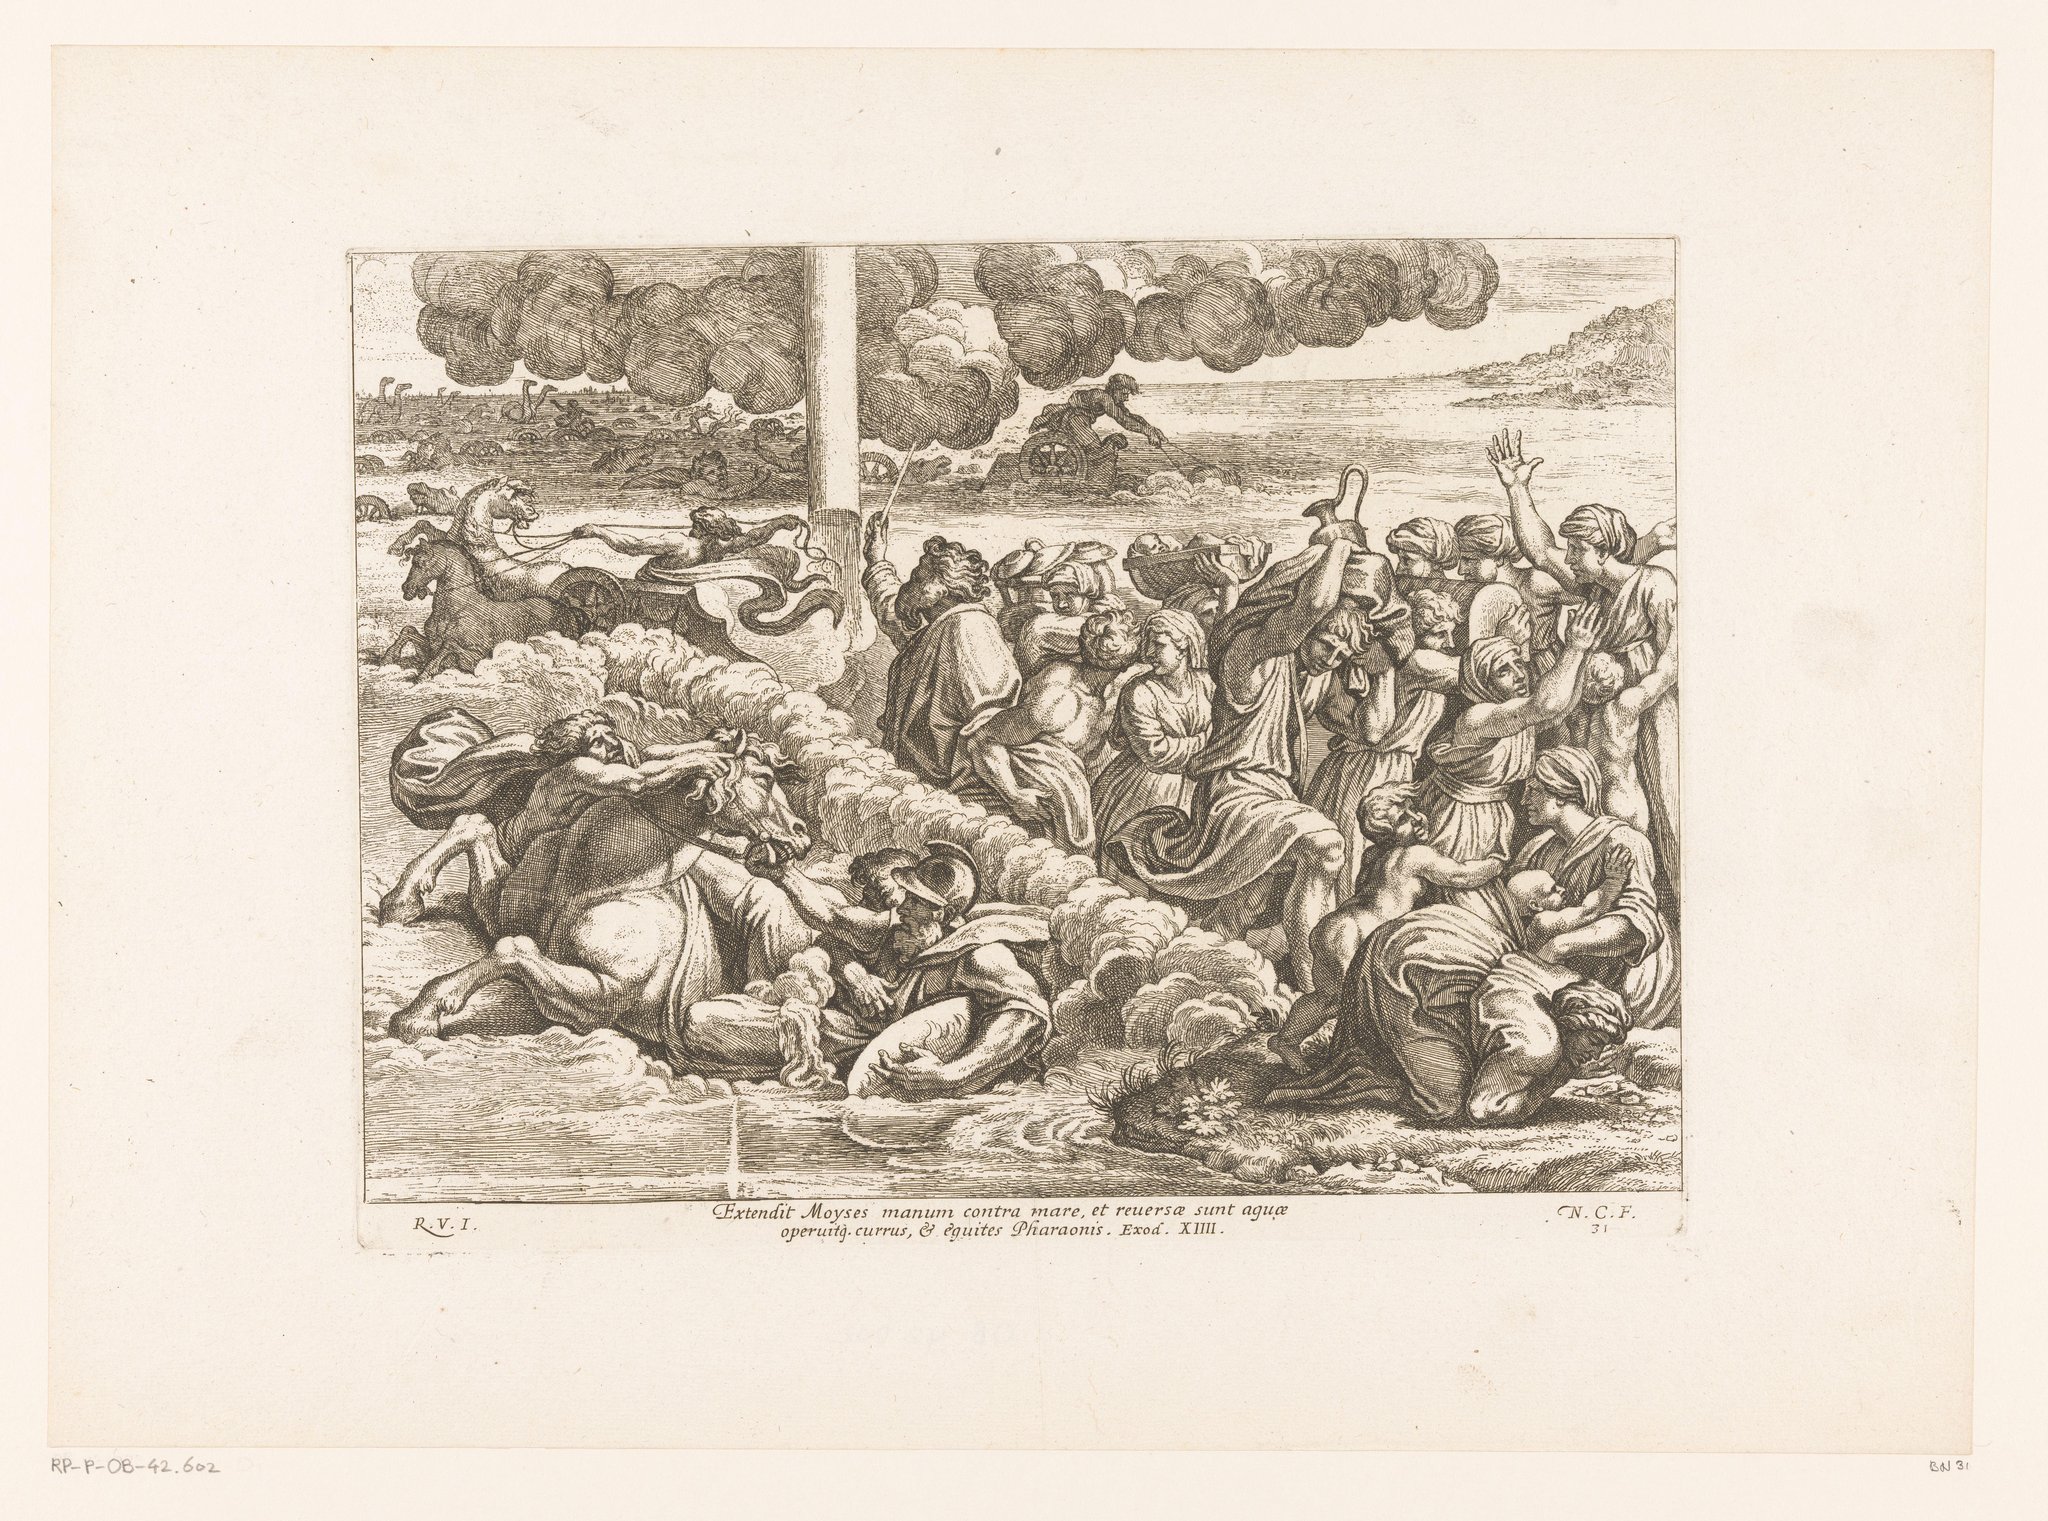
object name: print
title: Rafaël Bijbel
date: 1649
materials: paper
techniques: etching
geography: france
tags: passage through the red sea, pharaoh and his army engulfed in the red sea (israelites not or barely visible)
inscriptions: collector's mark: Lugt 2228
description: Prent uit de Sacrae Historiae Acta a Raphael Urbin in Vaticanis xystis ad picturae miraculum expressa, ook bekend als de Rafaël Bijbel. De serie bestaat uit 54 platen, waarvan twee titelprenten, de eerste met een opdracht aan Rafaël, de tweede met een opdracht aan Renard. De overige 52 platen betreffen composities naar schilderingen in de Loggia van Rafaël in het Vaticaan. De serie werd in 1649 uitgegeven door Pierre Mariette te Parijs.